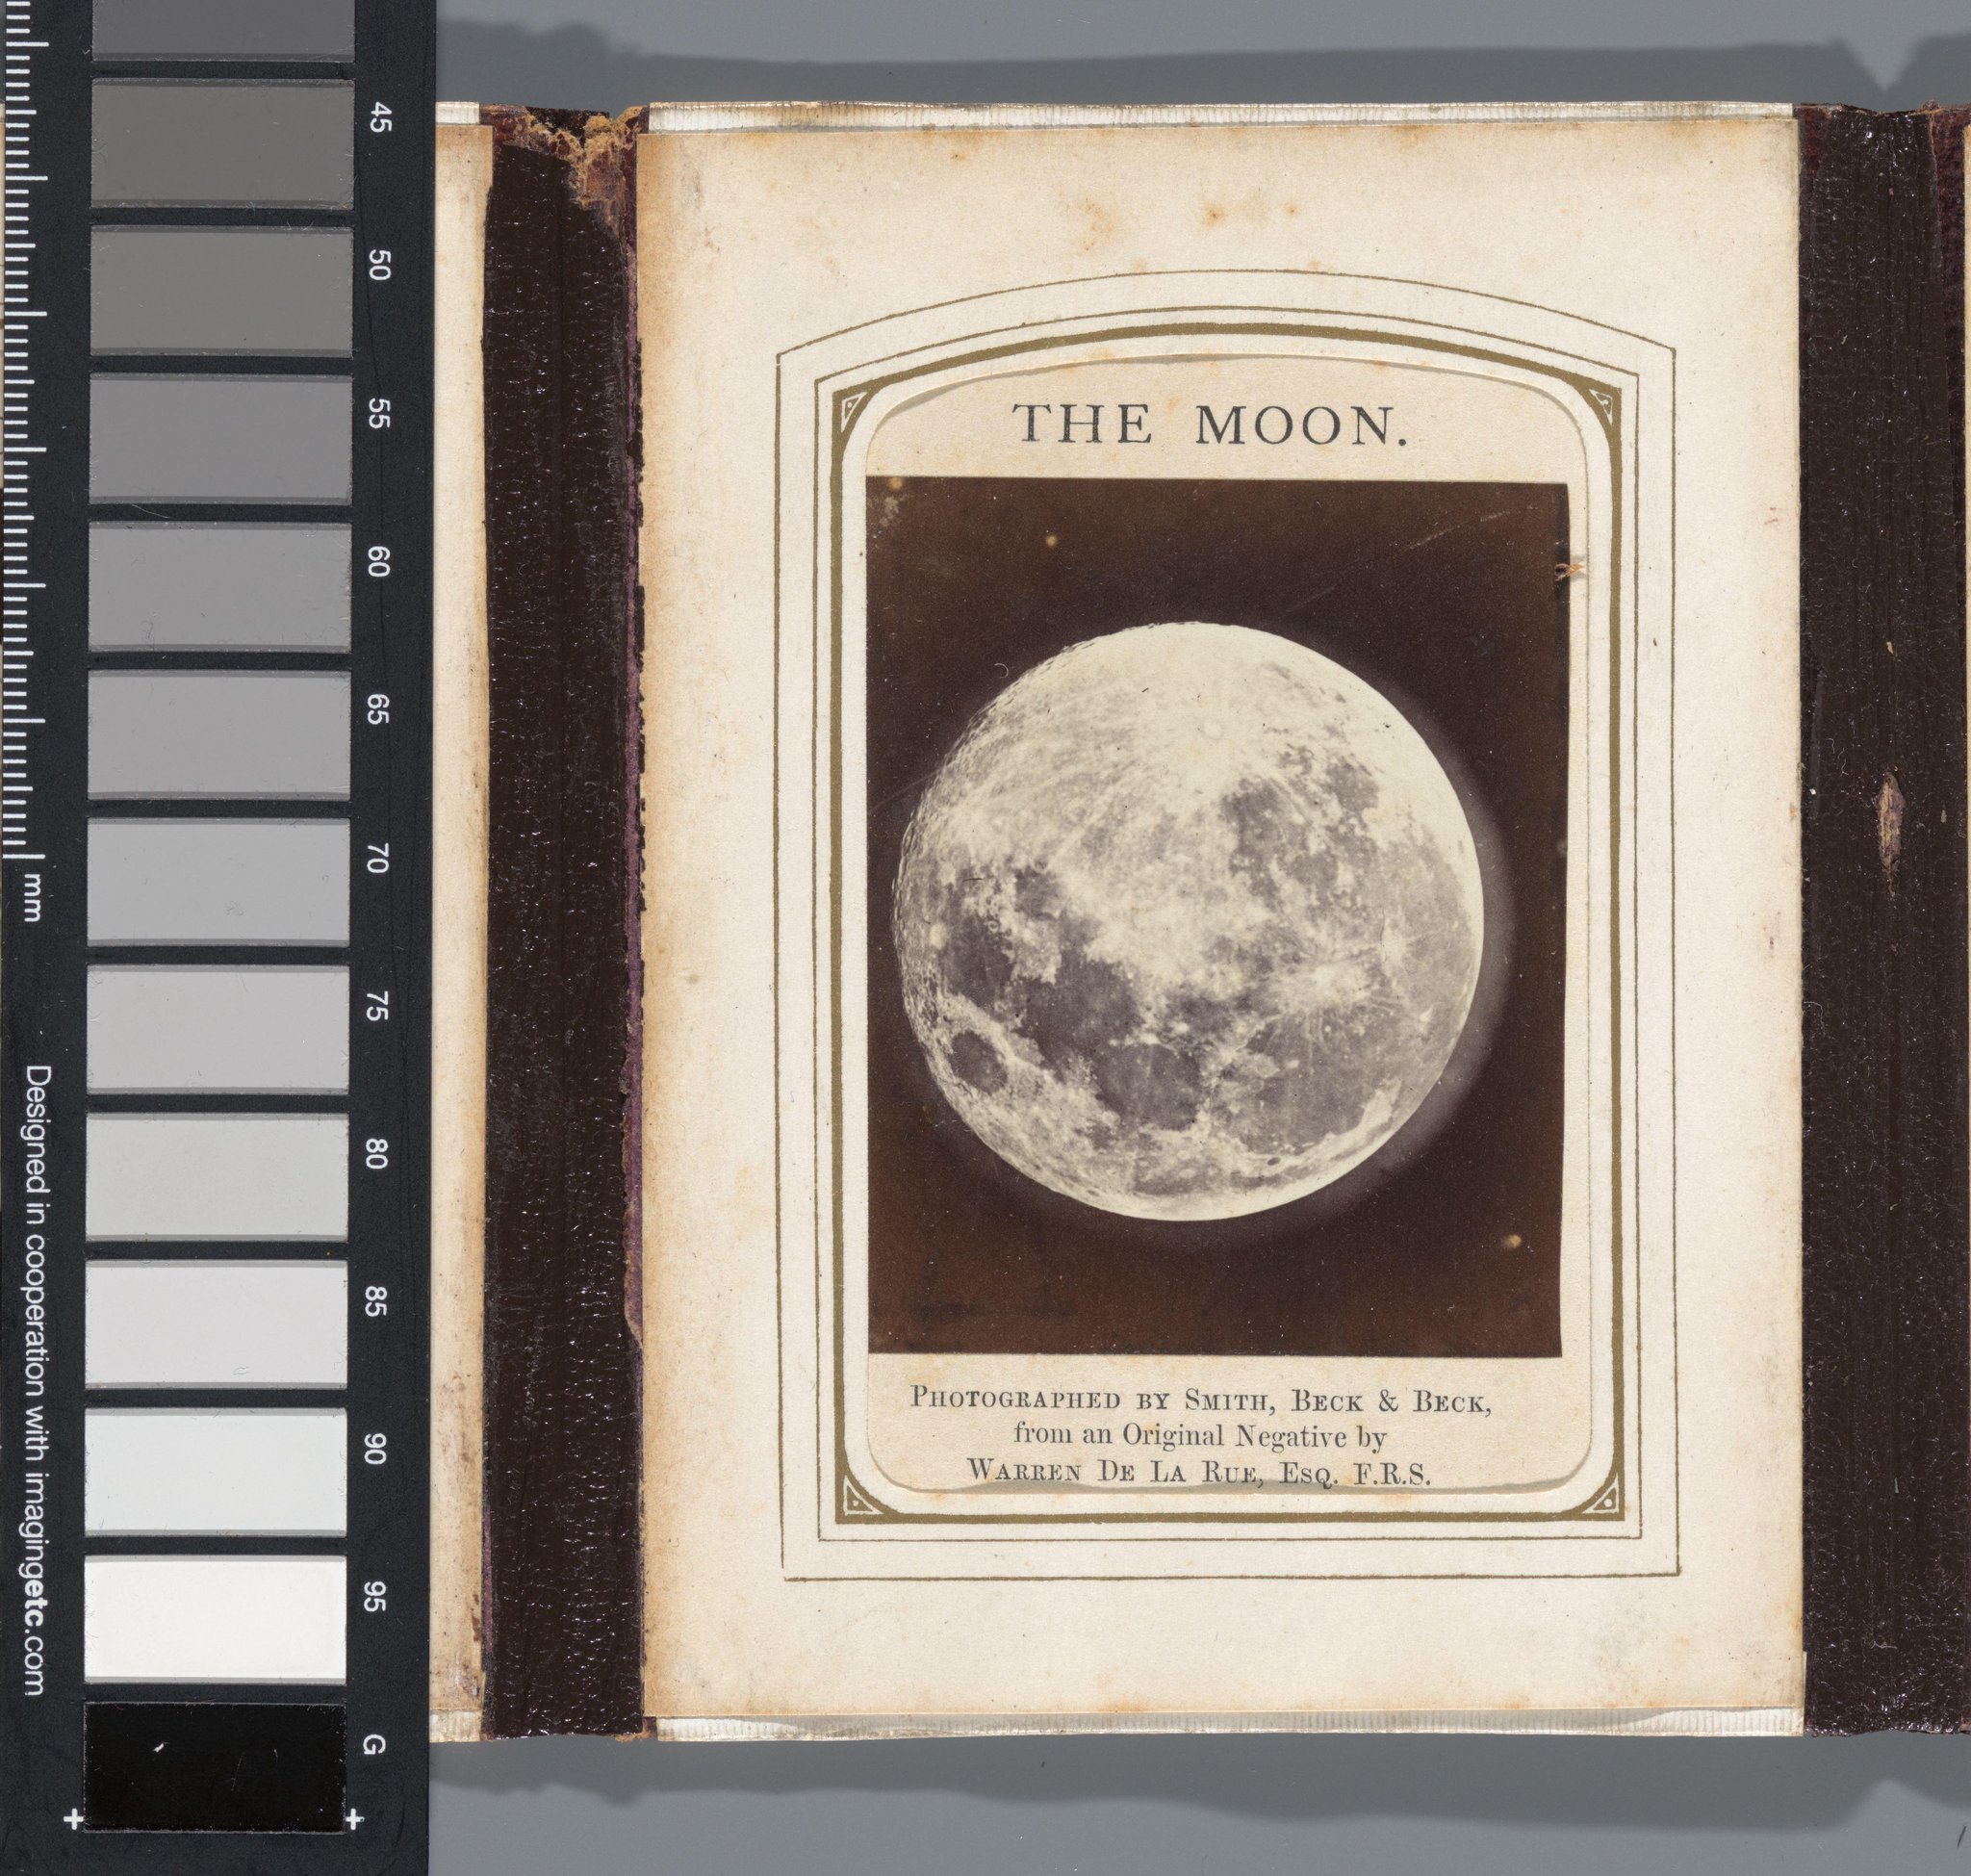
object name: photograph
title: Afnemende maan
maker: warren de la rue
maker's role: astronoom, fotograaf, scheikundige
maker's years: 1815-1889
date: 1866-1880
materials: cardboard, paper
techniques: albumen print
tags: waxing moon, i.e. facing this way: ), moon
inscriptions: inscription: ‘PHOTOGRAPHED BY SMITH, BECK & BECK,/ from an Original Negative by/WARREN DE LA RUE, ESQ, F.R.S.’